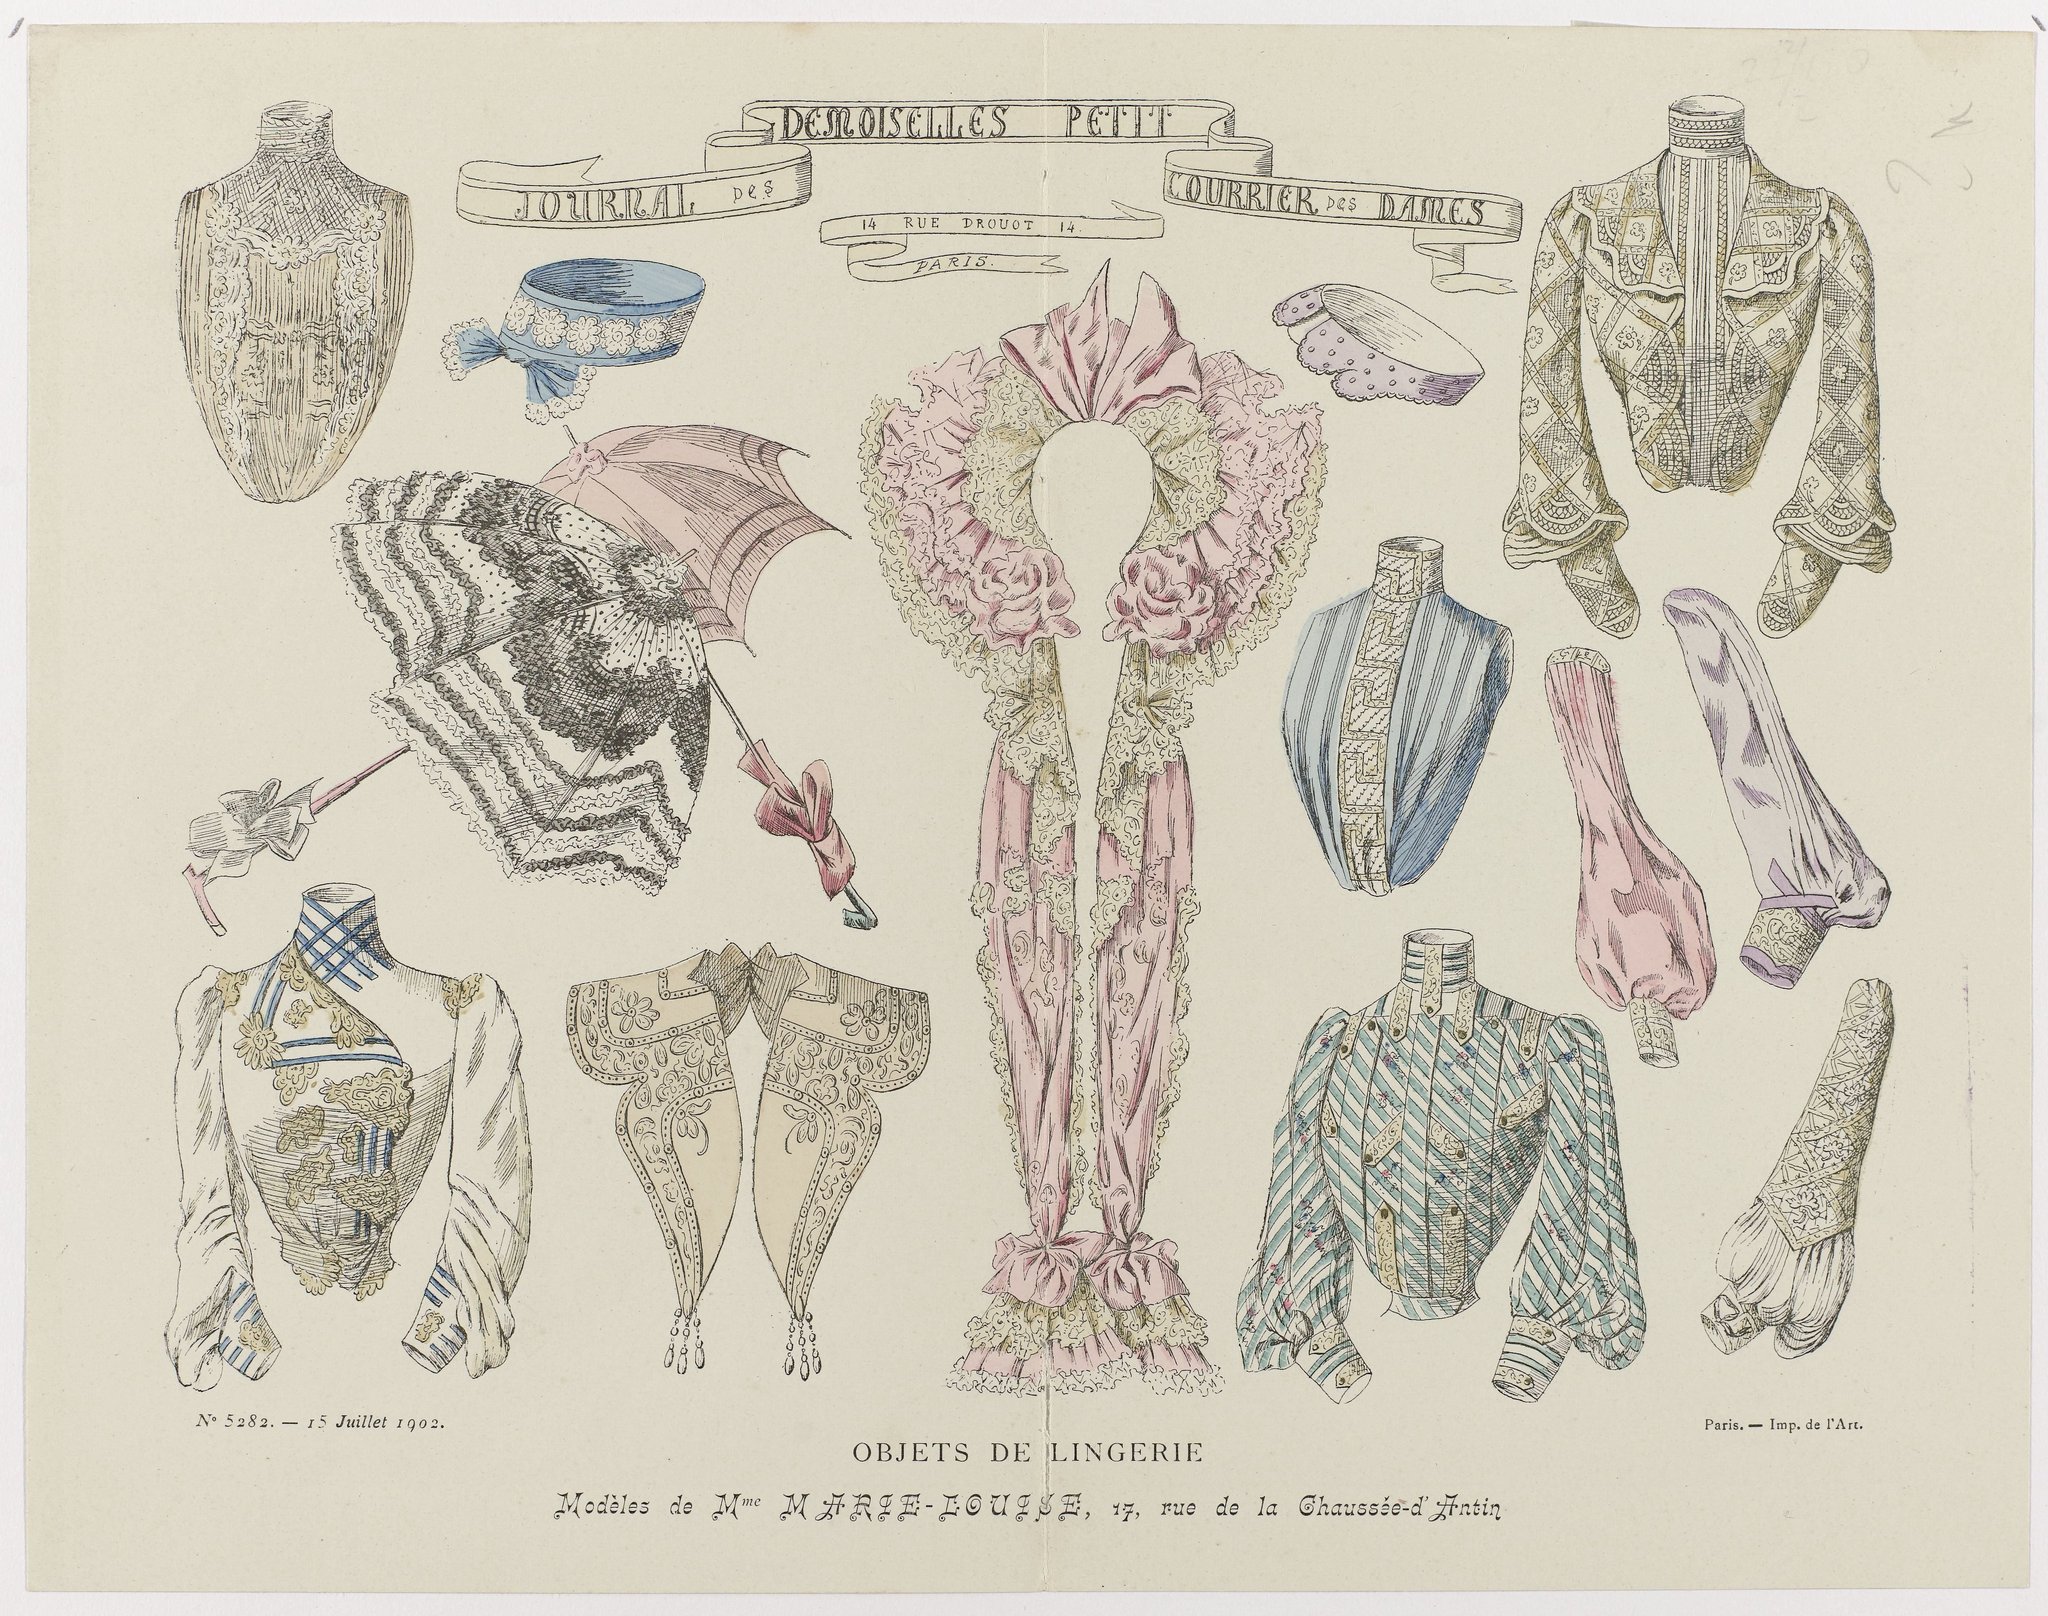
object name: fashion print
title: Journal des Demoiselles et Petit Courrier des Dames, 15 Juillet 1902, No. 5282 : Objets de Lingeri (...)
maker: Anonymous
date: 1902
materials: paper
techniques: etching, hand coloring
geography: paris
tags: clothing for the upper part of the body: blouse (+ women's clothes), parasol, sunshade (+ girls' clothes), piece of clothing covering the breast or décolleté (chemisette) (+ women's clothes), piece of clothing covering the breast or décolleté (guimpe) (+ women's clothes), neck-gear: collar (+ women's clothes), fashion plates, sleeves (+ women's clothes)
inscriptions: caption: ‘OBJETS DE LINGERIE / Modèles de Mme MARIE-LOUISE,17,rue de la Chaussée- d'Antin’, title: ‘JOURNAL DES DEMOISELLES PETIT COURRIER DES DAMES’, address: ‘14 RUE DROUOT 14 / PARIS’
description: Verschillende artikelen, waaronder parasols, guimpe, kragen, blouses en losse mouwen. Volgens het onderschrift: 'modèles' van Marie-Louise. Prent uit het modetijdschrift Journal des Demoiselles (et Petit Courrier des Dames) (1833 -1922).